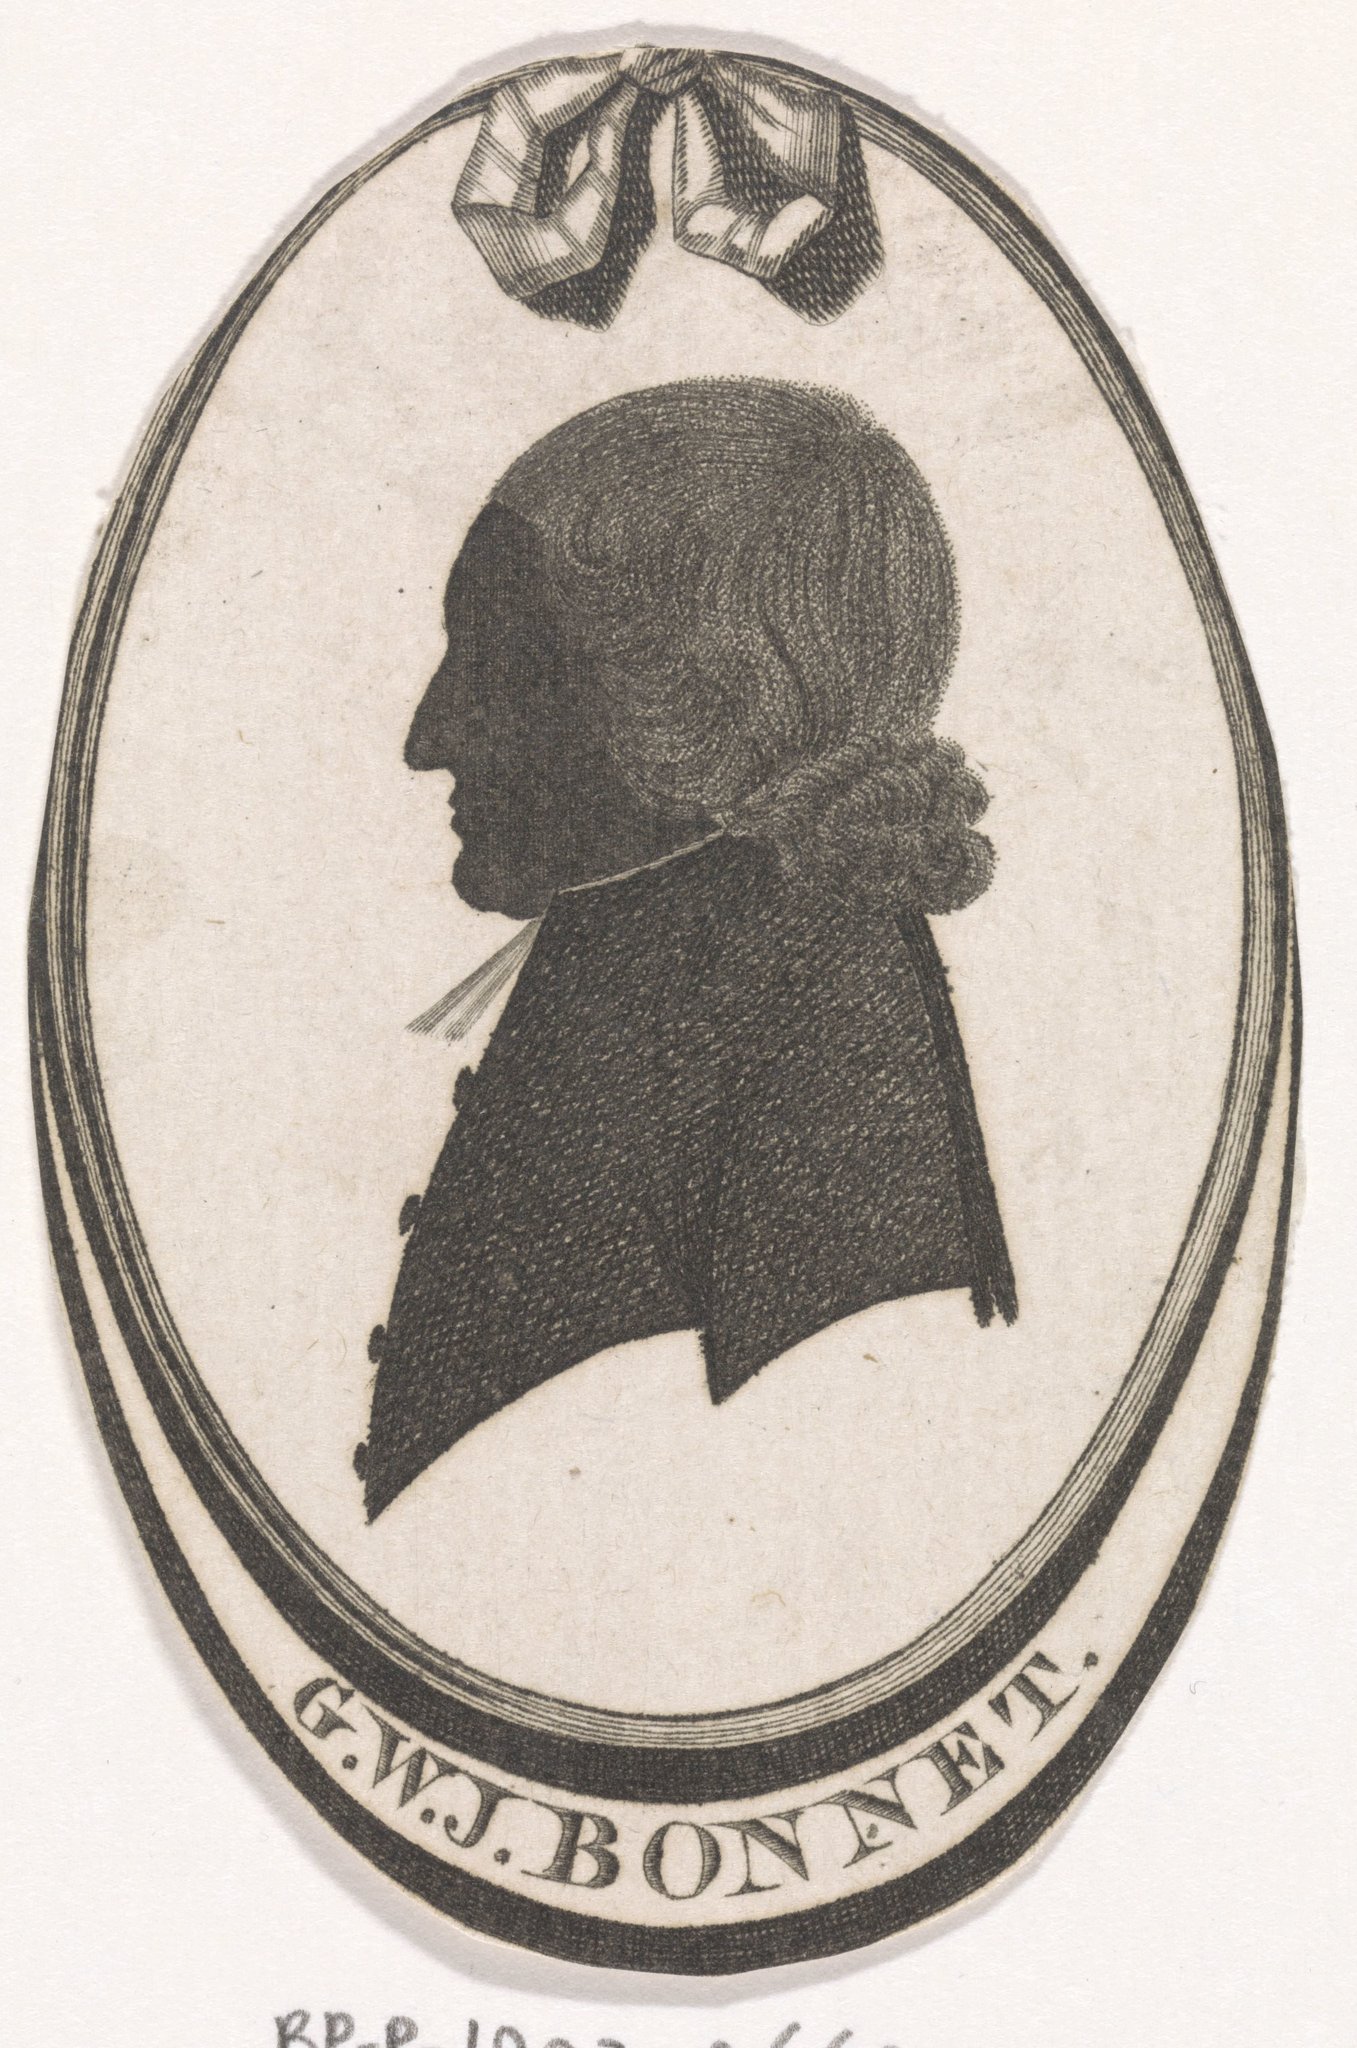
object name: print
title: Silhouetportret van Gijsbert Weijer Jan Bonnet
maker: govert kitsen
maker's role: print maker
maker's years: 1766-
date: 1776-1810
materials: paper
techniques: engraving, etching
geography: rotterdam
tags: rotterdam, wig (+ sideview, profile)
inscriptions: collector's mark: Lugt 2228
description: Portretbuste in profiel naar links van Gijsbert Weijer Jan Bonnet. Hij was predikant in verschillende Nederlandse steden.